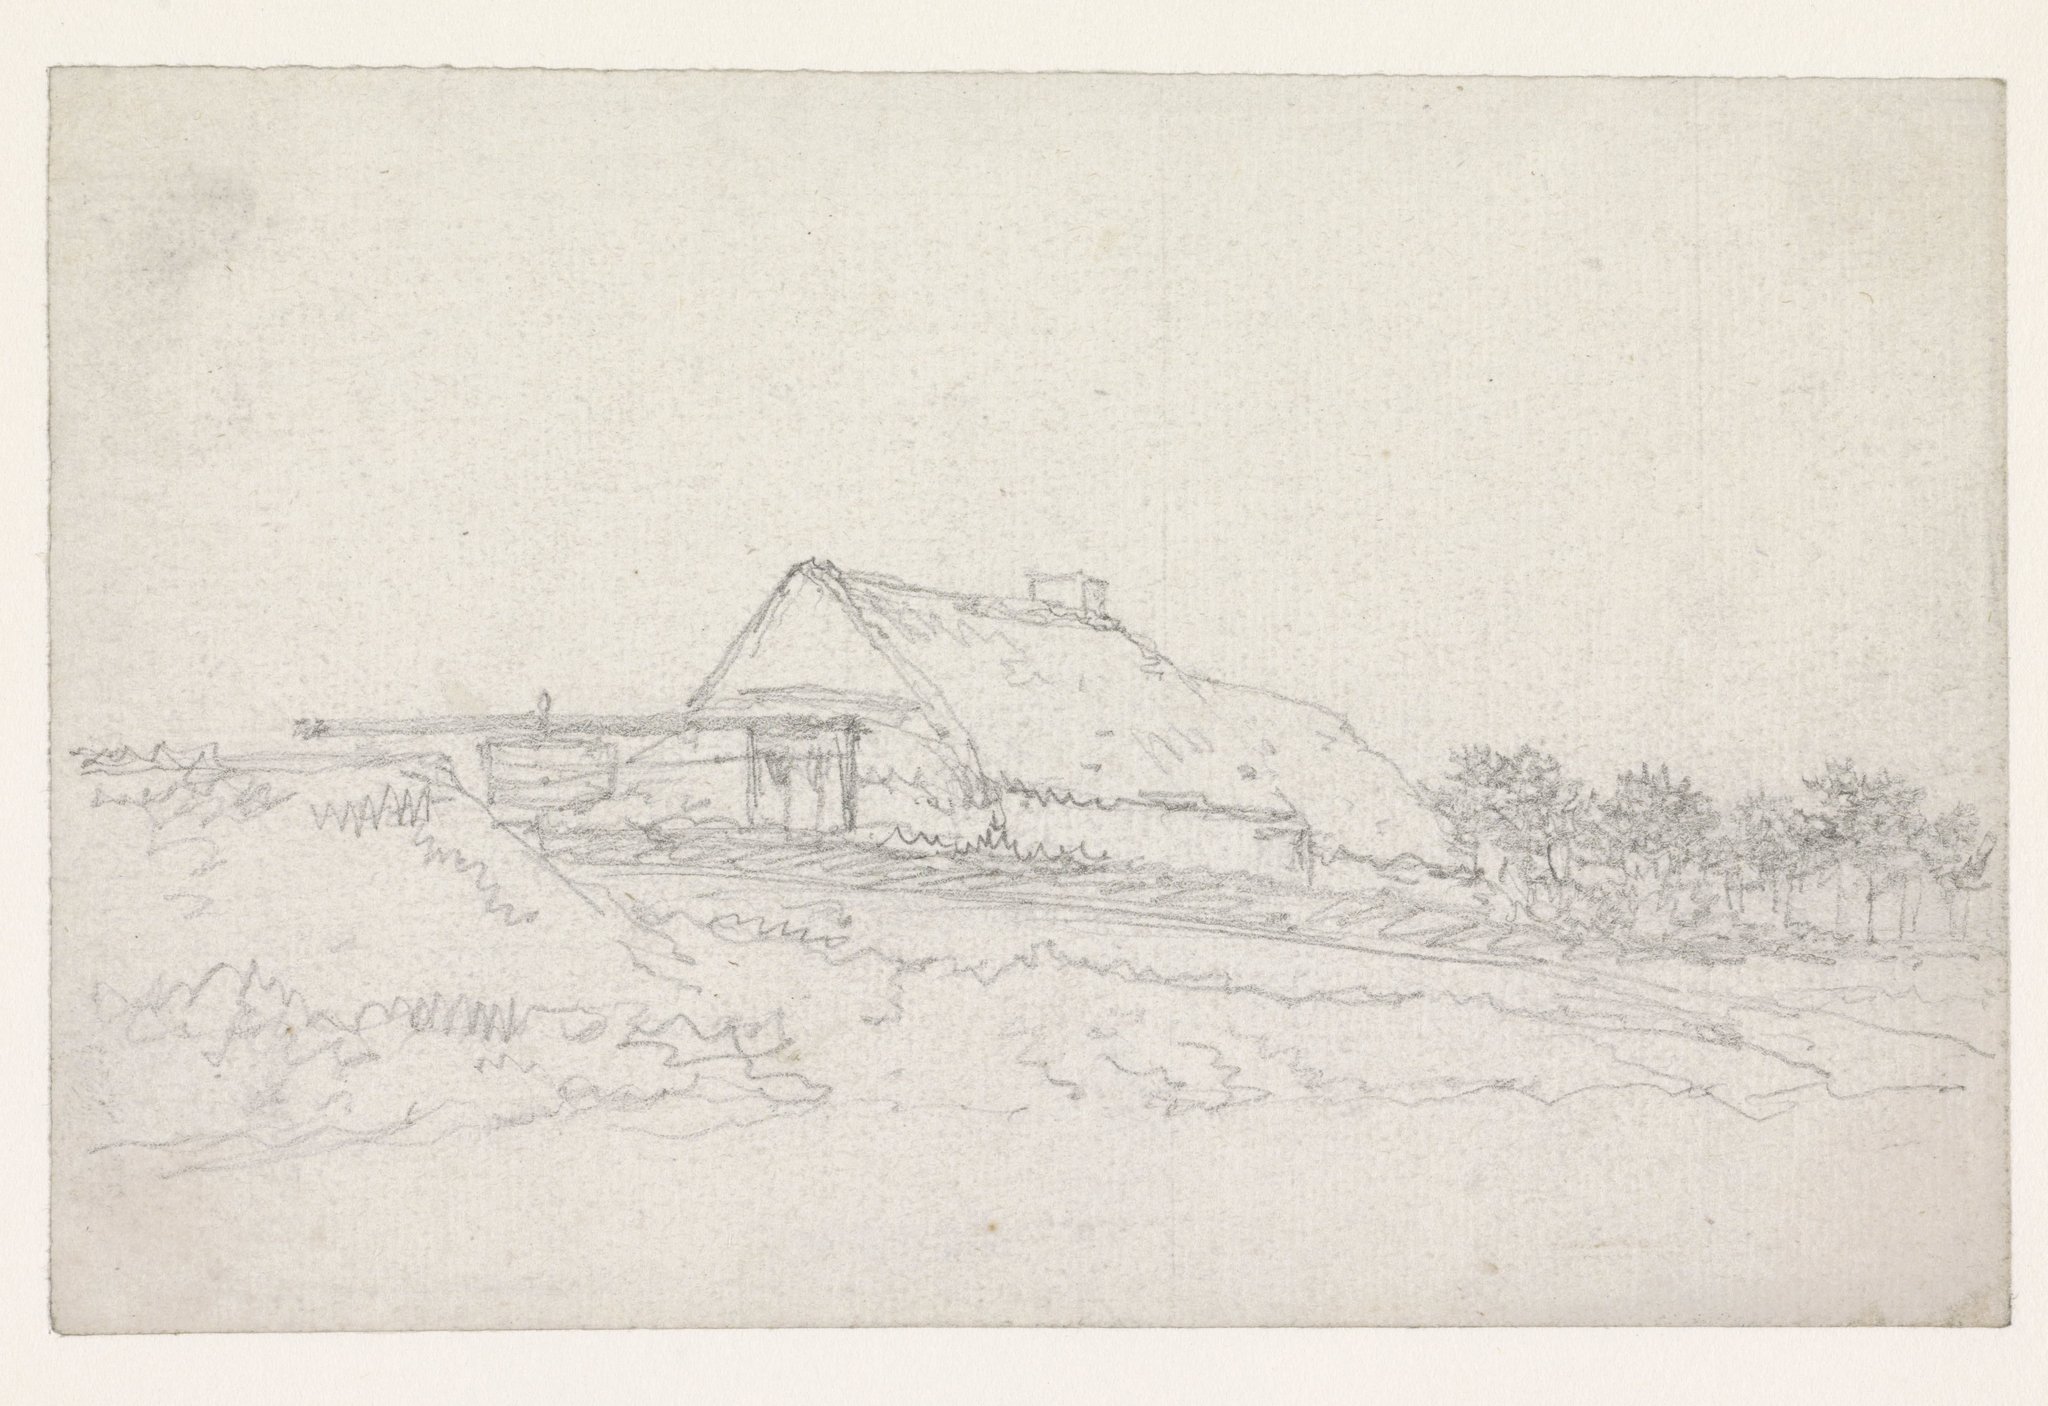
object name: drawing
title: Boerderij met put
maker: georges michel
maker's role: draughtsman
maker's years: 1763-1843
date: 1773-1843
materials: paper, pencil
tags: farm or solitary house in landscape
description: Een van 120 tekeningen, afkomstig uit een 19e eeuws album met tekeningen van Georges Michel.